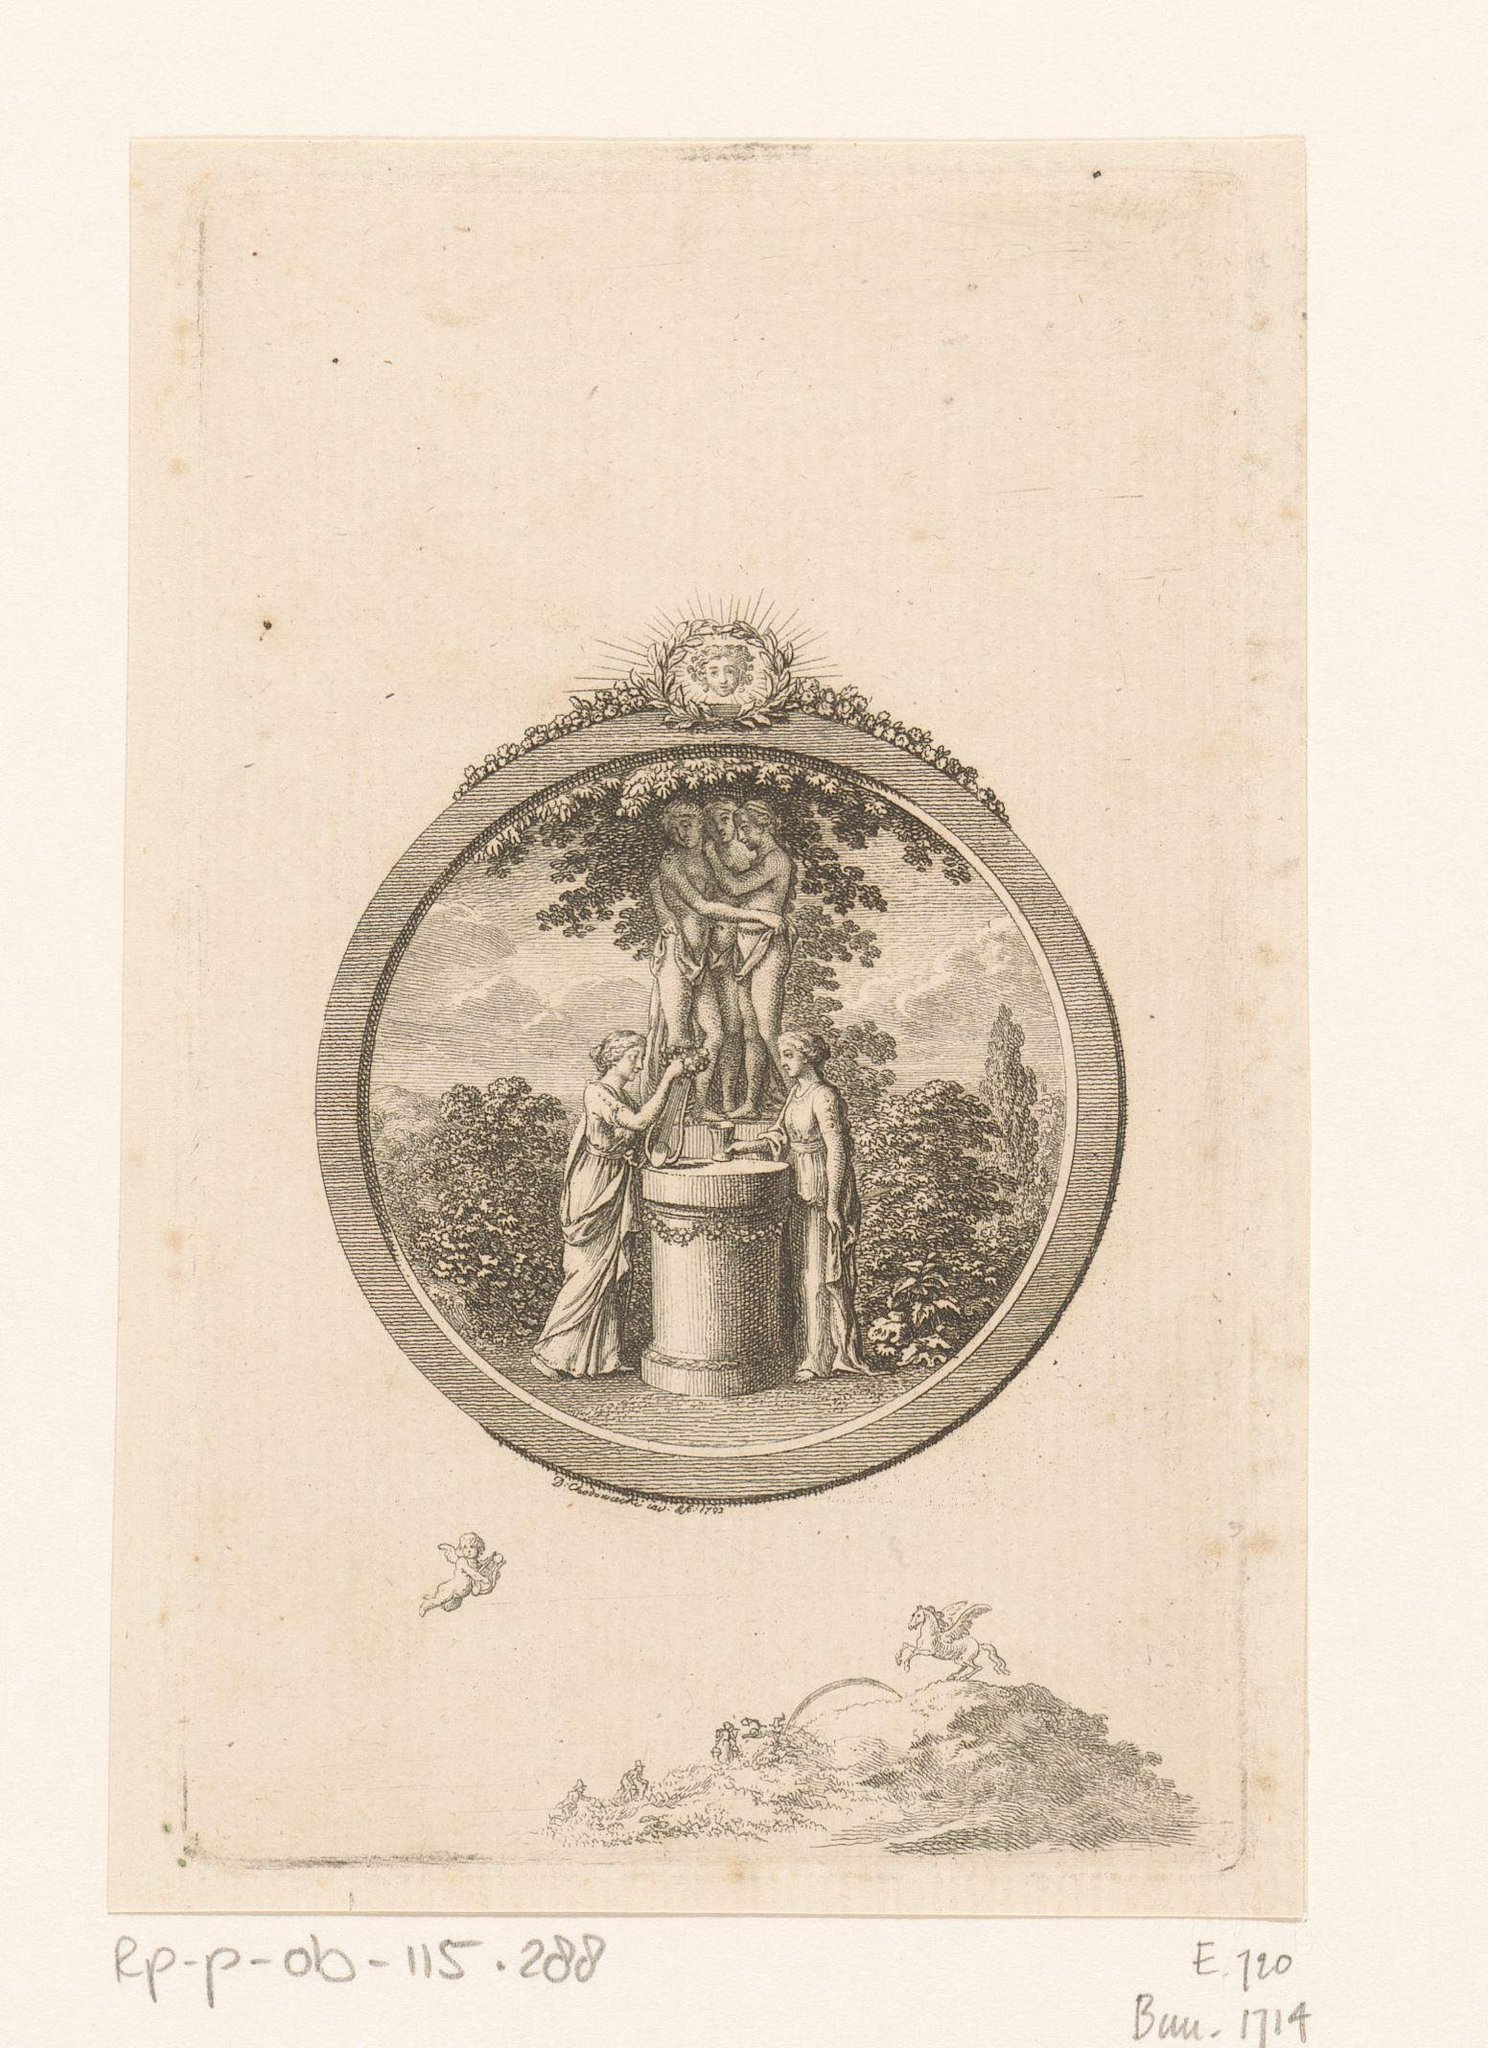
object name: print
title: Twee vrouwen eren de drie gratiën met bloemen en muziek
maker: daniel nikolaus chodowiecki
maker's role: draughtsman, print maker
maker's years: 1726-1801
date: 1793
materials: paper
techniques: etching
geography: berlin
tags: pegasus, the winged horse, lyre, cithara, psaltery, ornament ~ medallion, graces (charites), generally three in number; 'gratie' (ripa), sacrifice ~ non-christian religions, crowning with laurel, ornament ~ festoon, garland, cupids: 'amores', 'amoretti', 'putti'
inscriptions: collector's mark: Lugt 2228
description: Latere staat gebruikt voor: Matthisson, Friedrich von. Gedichte von Friedrich Matthisson. 3de druk. Zürich: Orell, Gessner, Füssli & Comp., 1794.